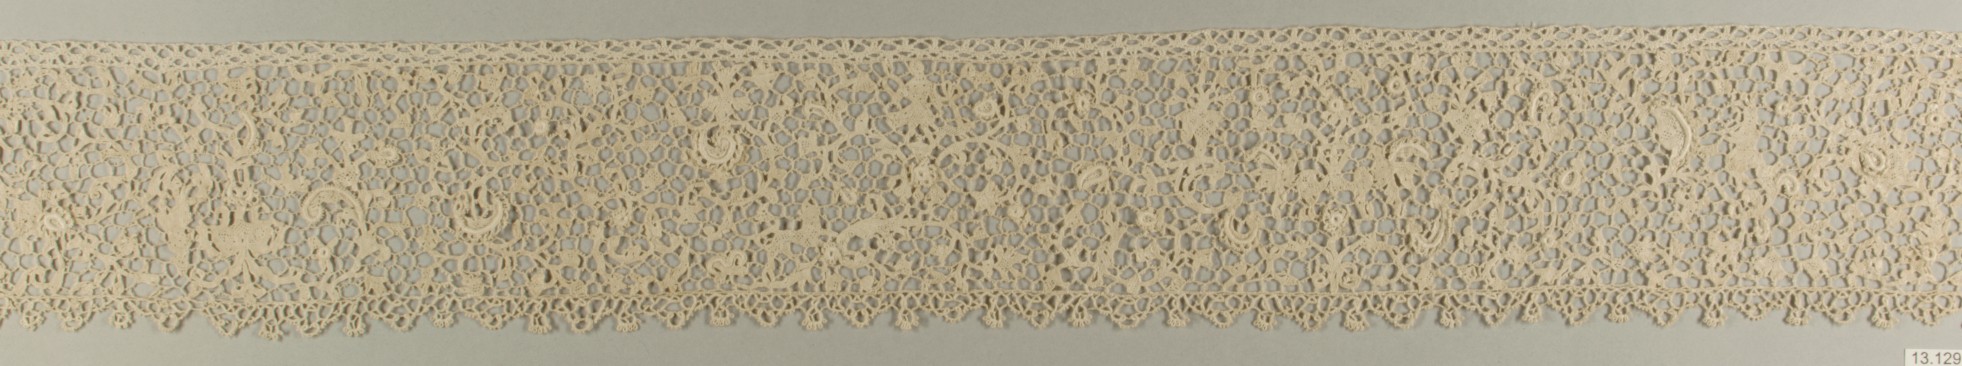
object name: border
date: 1601-1800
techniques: lace